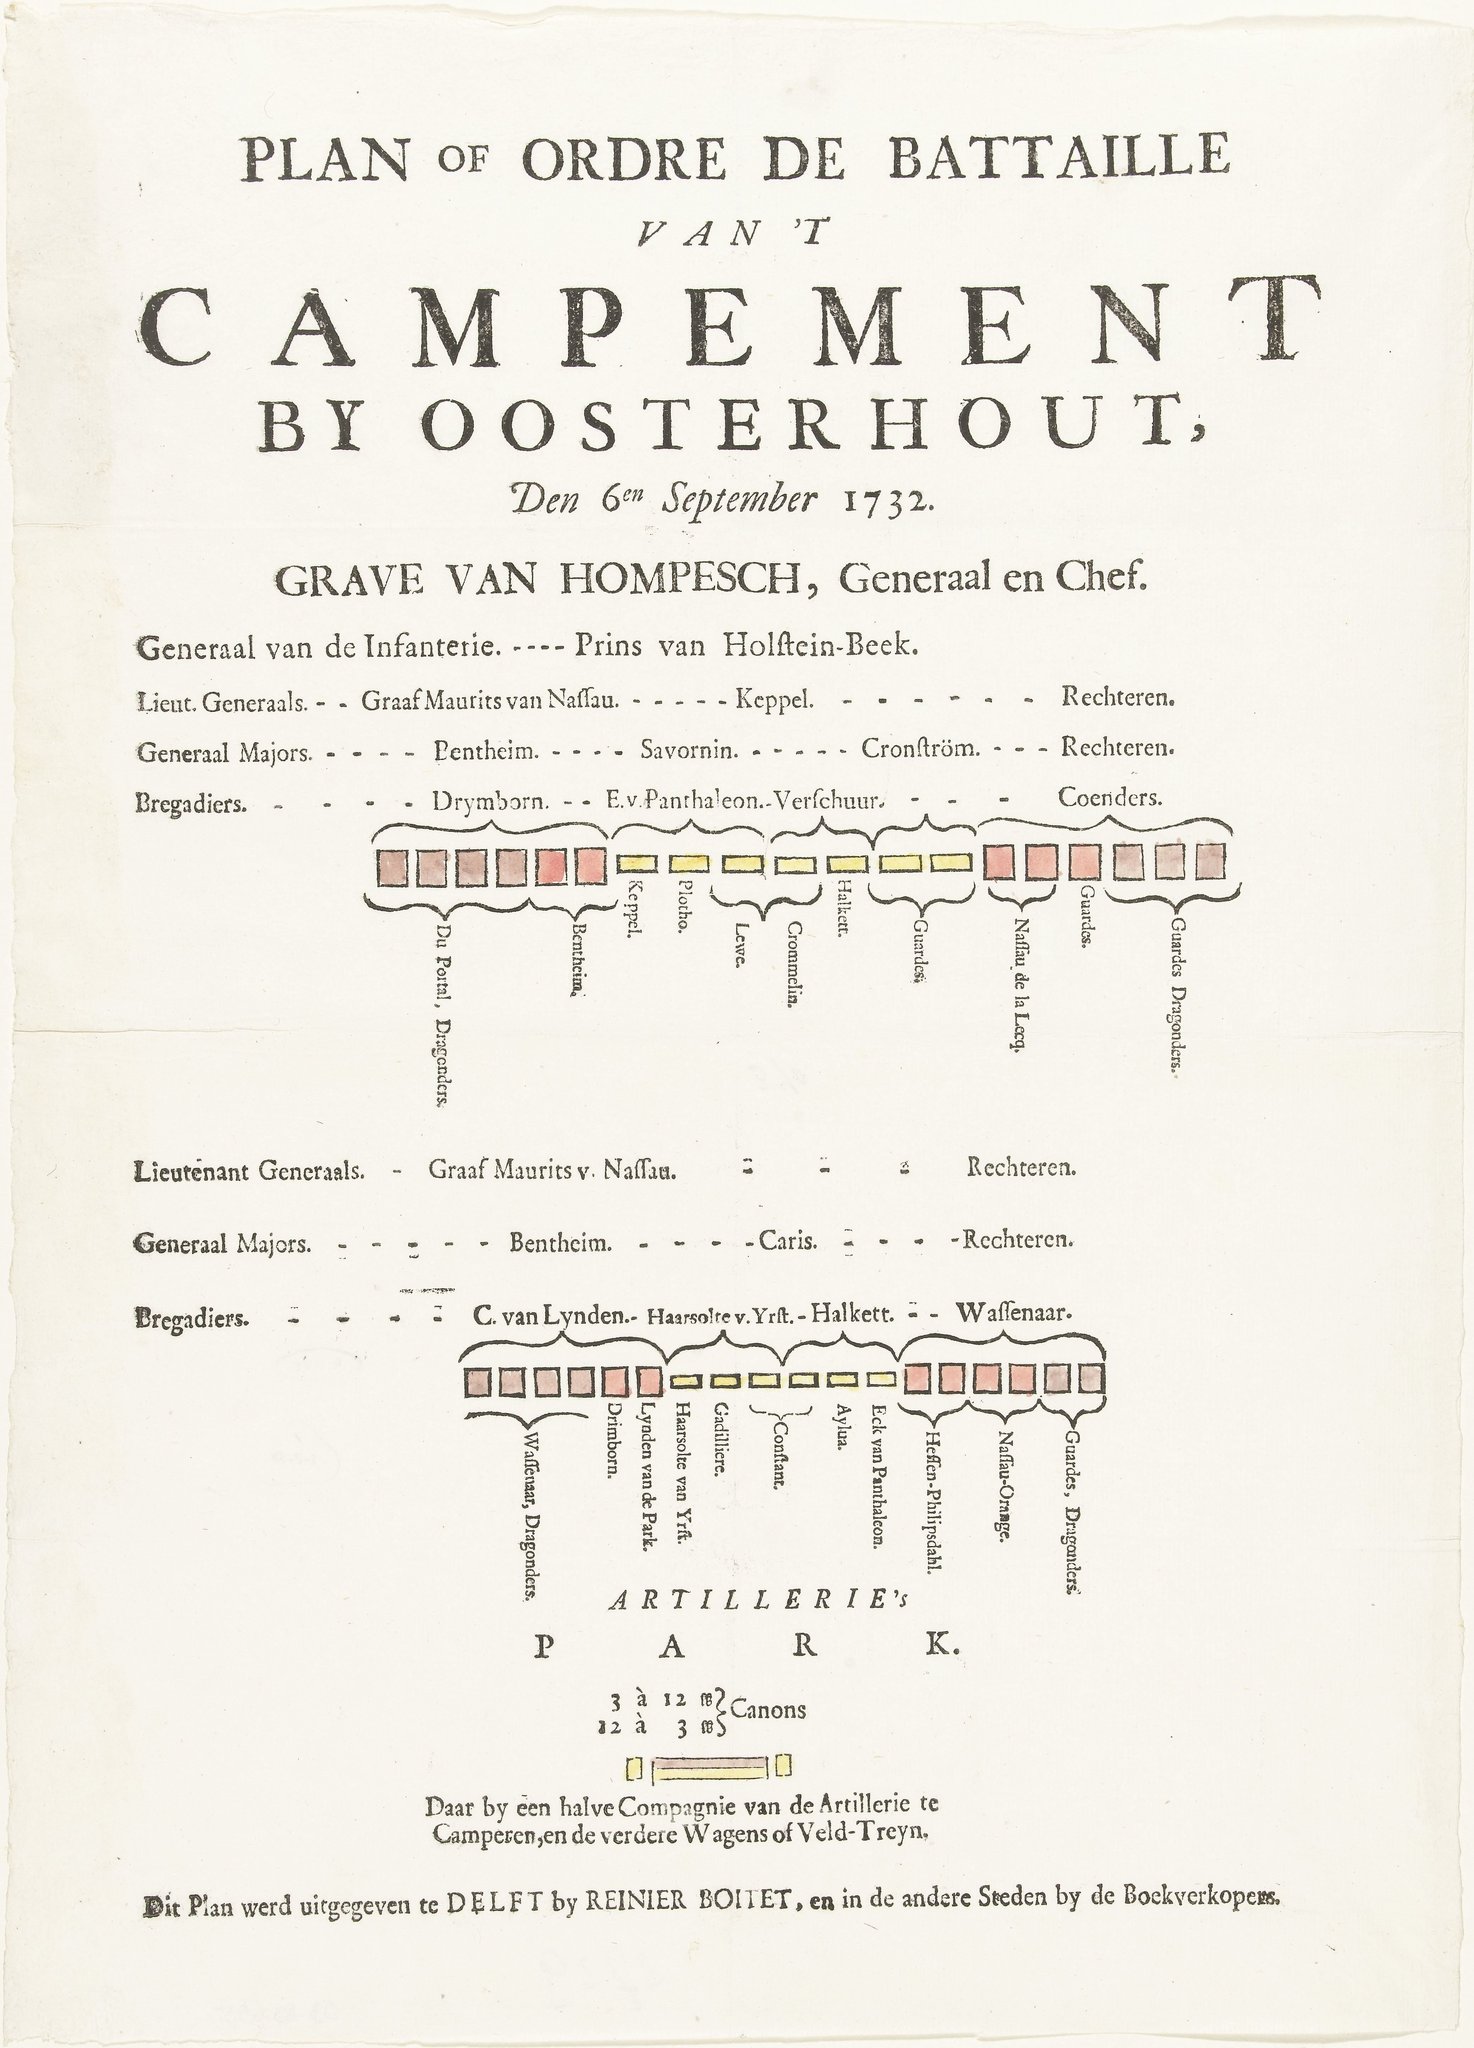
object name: text sheet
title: Plan of Ordre de Battaille van 't Campement by Oosterhout, Den 6en September 1732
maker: reinier boitet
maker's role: publisher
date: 1732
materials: paper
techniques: hand coloring, letterpress printing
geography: delft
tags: battle arrays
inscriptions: collector's mark: Lugt 2228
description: Slagorde in het Hollandse legerkamp bij de grote legeroefening Kampement van Oosterhout op de heide bij Oosterhout, 6 september 1732, onder bevel van de generaal Graaf van Hompesch.